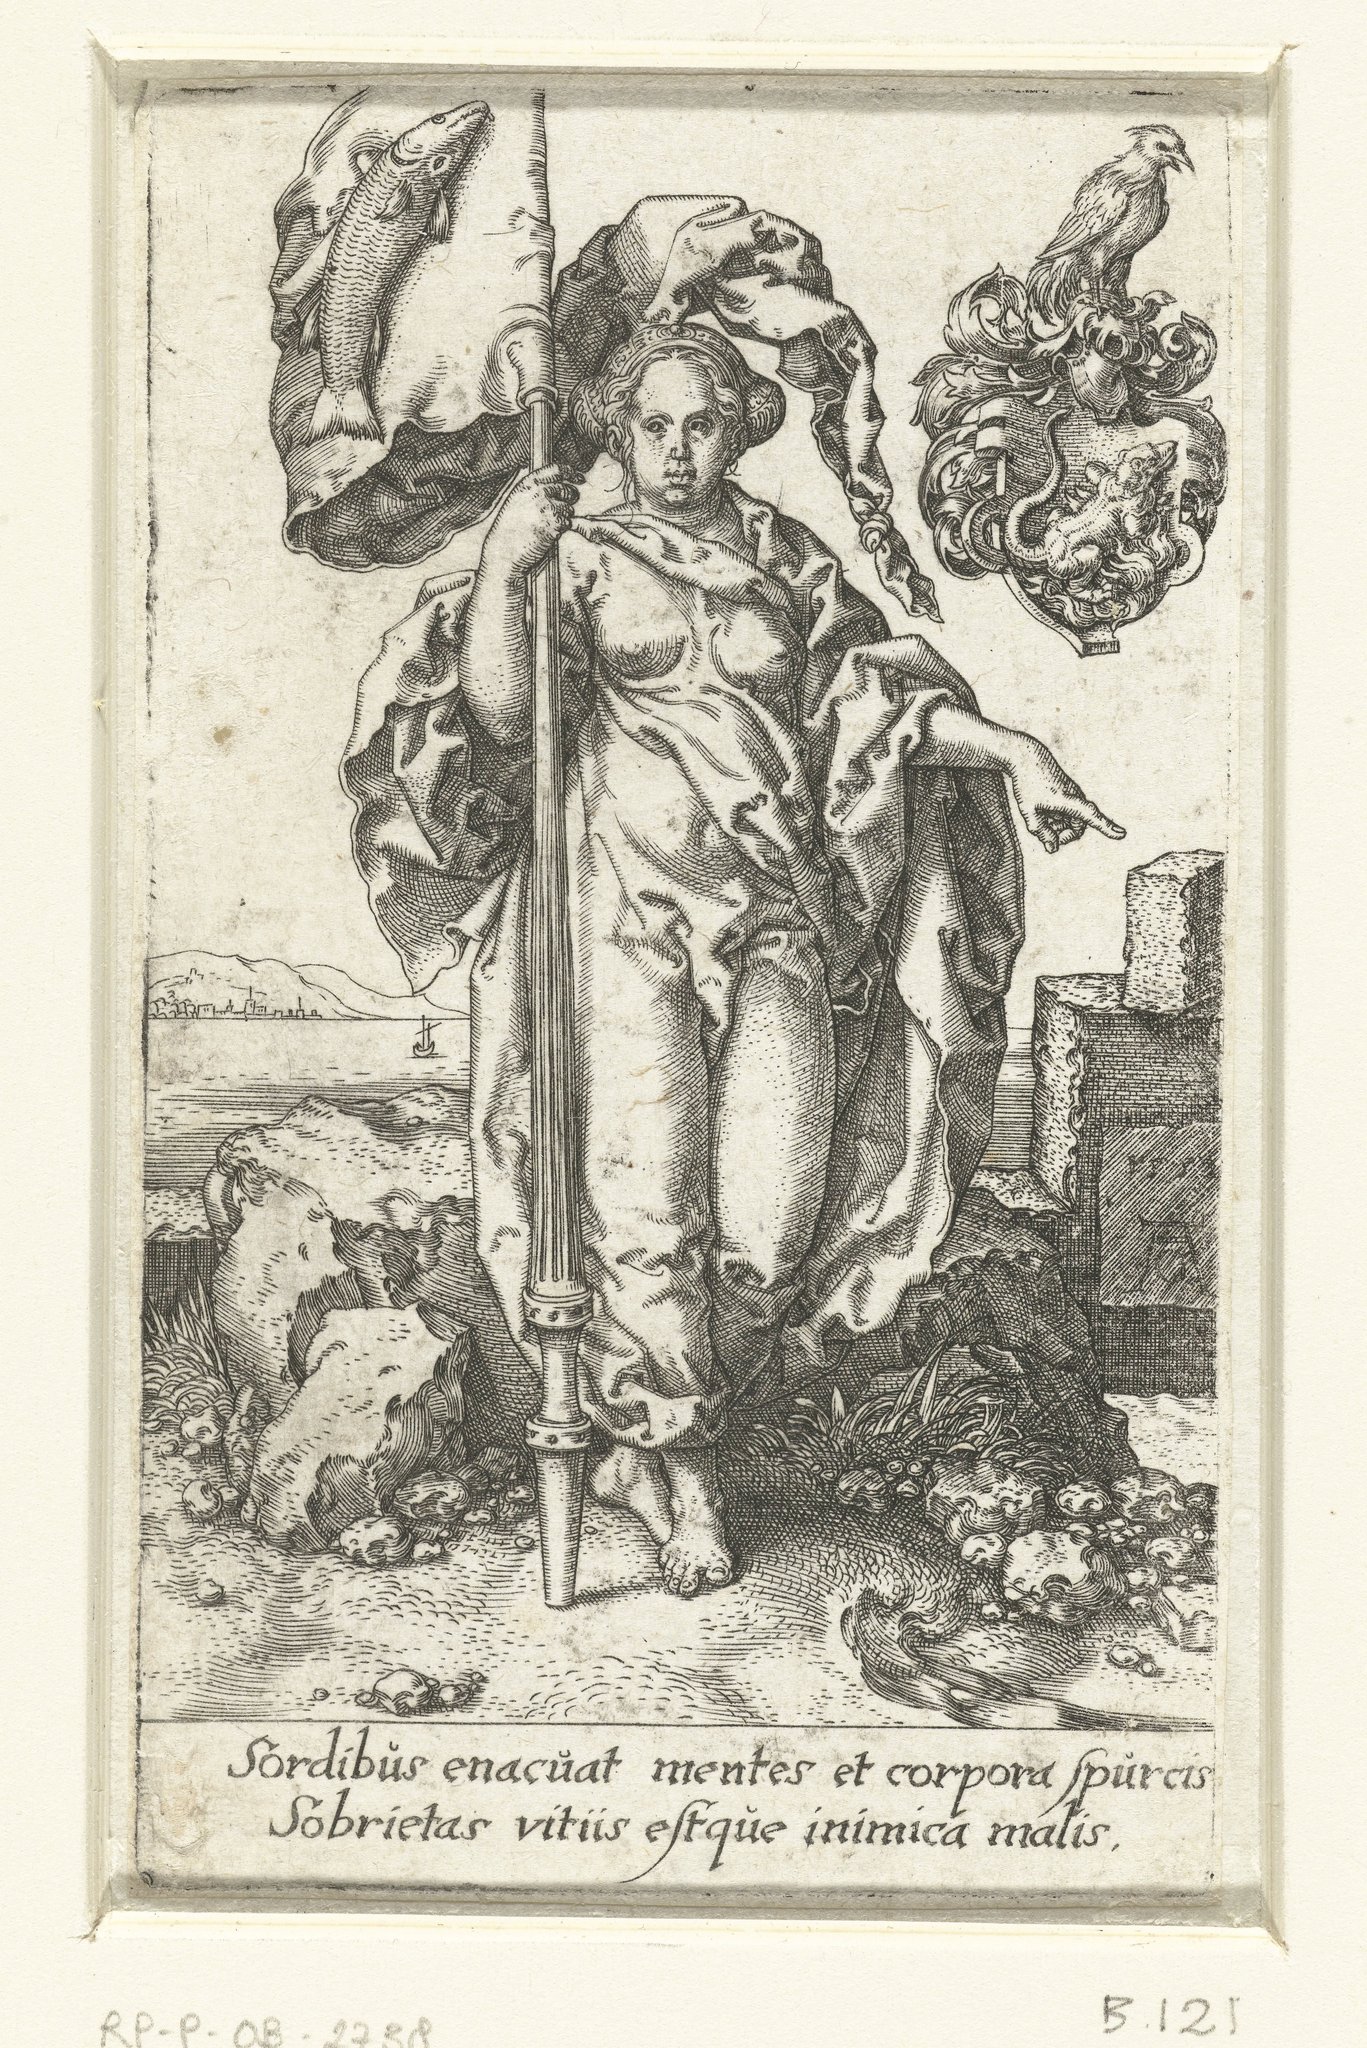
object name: print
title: Zeven Deugden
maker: heinrich aldegrever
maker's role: draughtsman, print maker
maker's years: 1502-1561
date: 1552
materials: paper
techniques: engraving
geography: germany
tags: temperance, 'temperantia'; 'temperanza' (ripa) ~ one of the four cardinal virtues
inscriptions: number: ‘110’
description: Personificatie van de gematigheid. Vrouw wijzend met haar linkerhand, in haar rechterhand een vaandel met daarom een afbeelding van een vis. Rechtsboven een wapenschild met een salamander in het vuur, daarboven een vogel. Onder de voorstelling een tweeregelige tekst in het Latijn. Vijfde prent uit een serie van zeven.